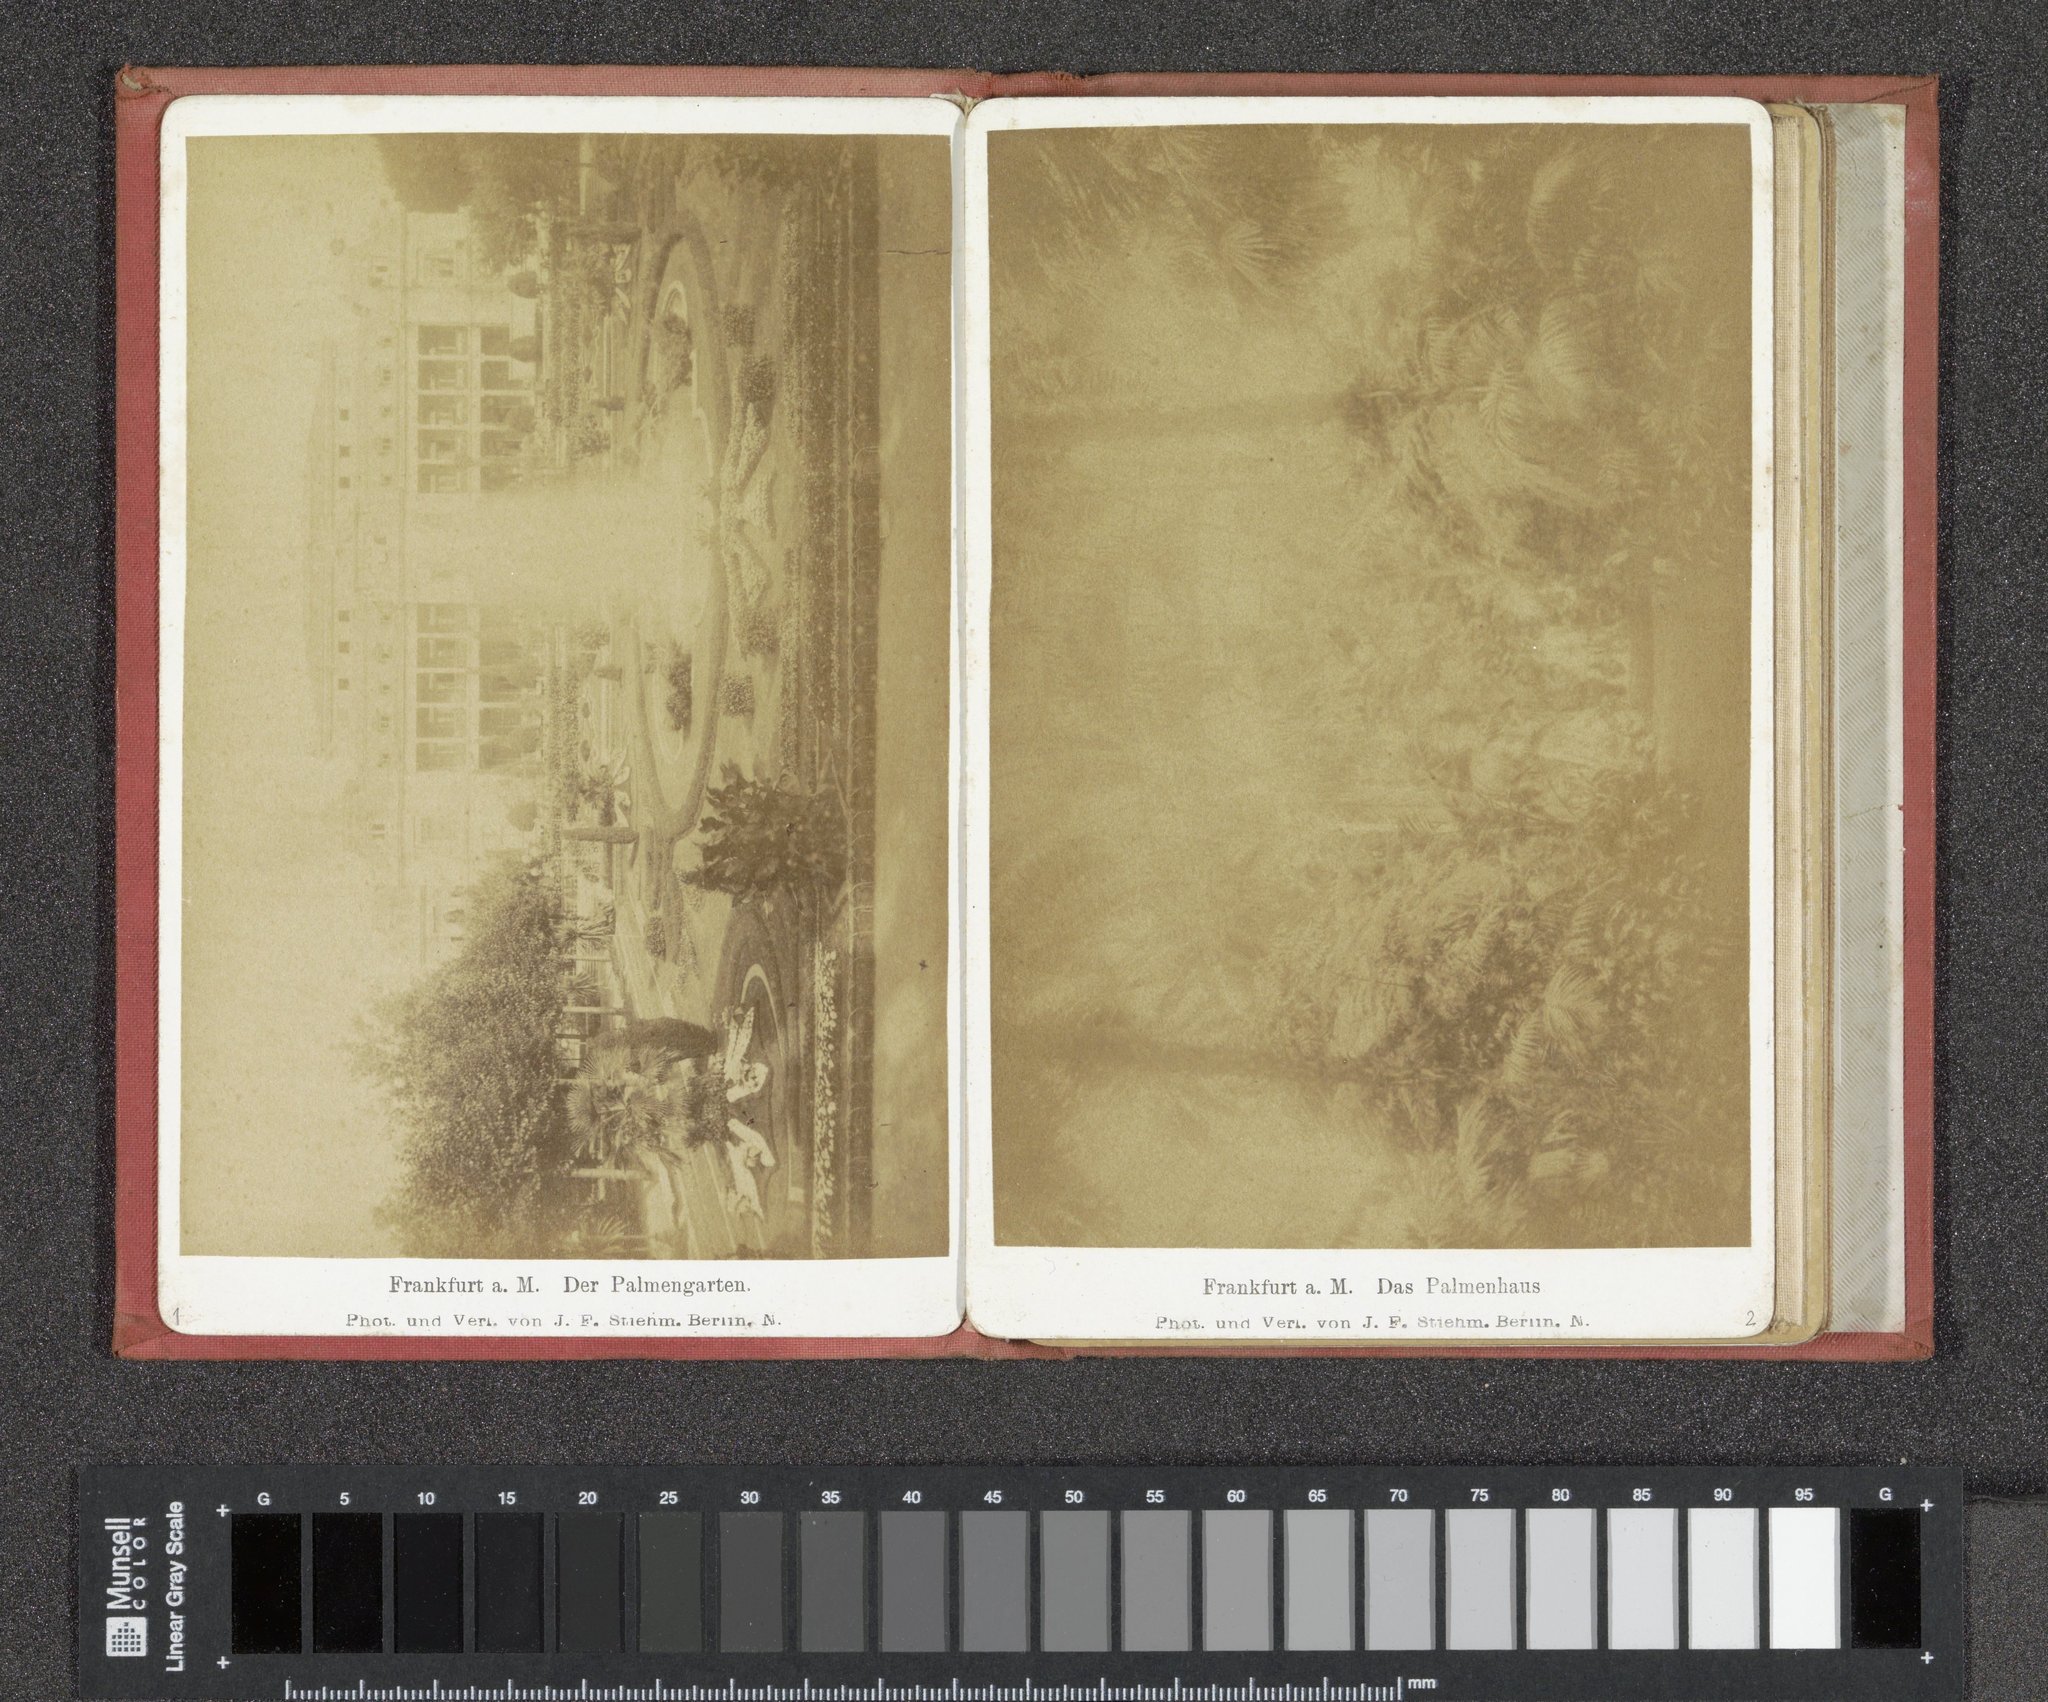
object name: photograph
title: Gezicht op het Gesellschaftshaus (feestzaal) met fontein ervoor in de Palmentuin van Frankfurt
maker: johann friedrich stiehm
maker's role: fotograaf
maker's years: 1826-1902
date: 1871-1880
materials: cardboard, paper, photographic support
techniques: albumen print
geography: palmengarten frankfurt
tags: garden fountain, botanic garden, 'hortus botanicus', façade (of house or building), public gardens, park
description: Onderdeel van Palmentuin in Frankfurt am Main.